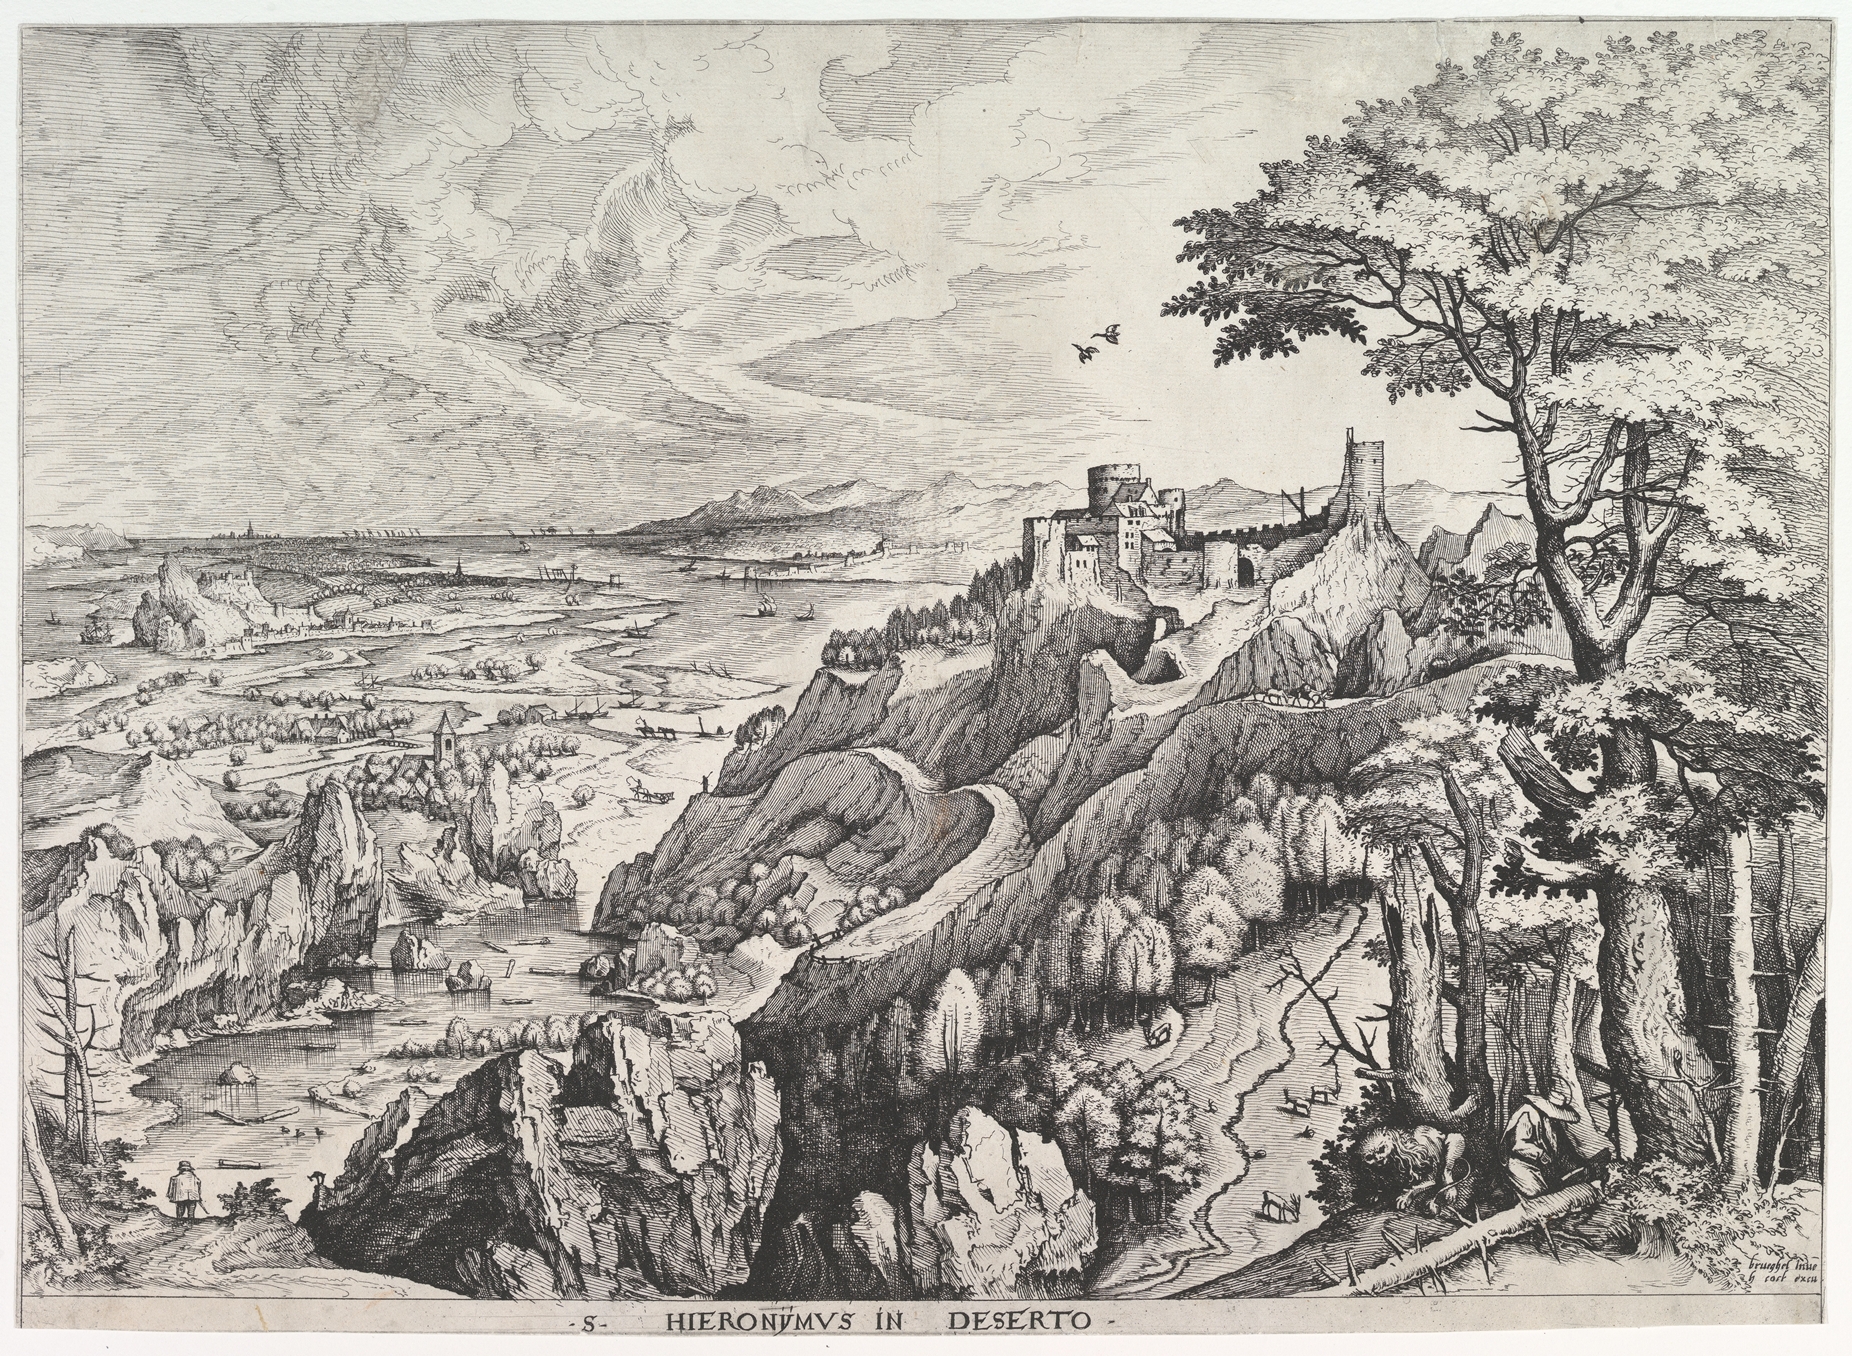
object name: print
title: St. Jerome in the Wilderness (S. Hieronymus in Deserto), from "The Large Landscapes"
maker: johannes van doetecum i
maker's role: artist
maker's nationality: netherlandish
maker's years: 1528-1605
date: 1555-1556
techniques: engraving, etching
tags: lions,landscapes,saint jerome